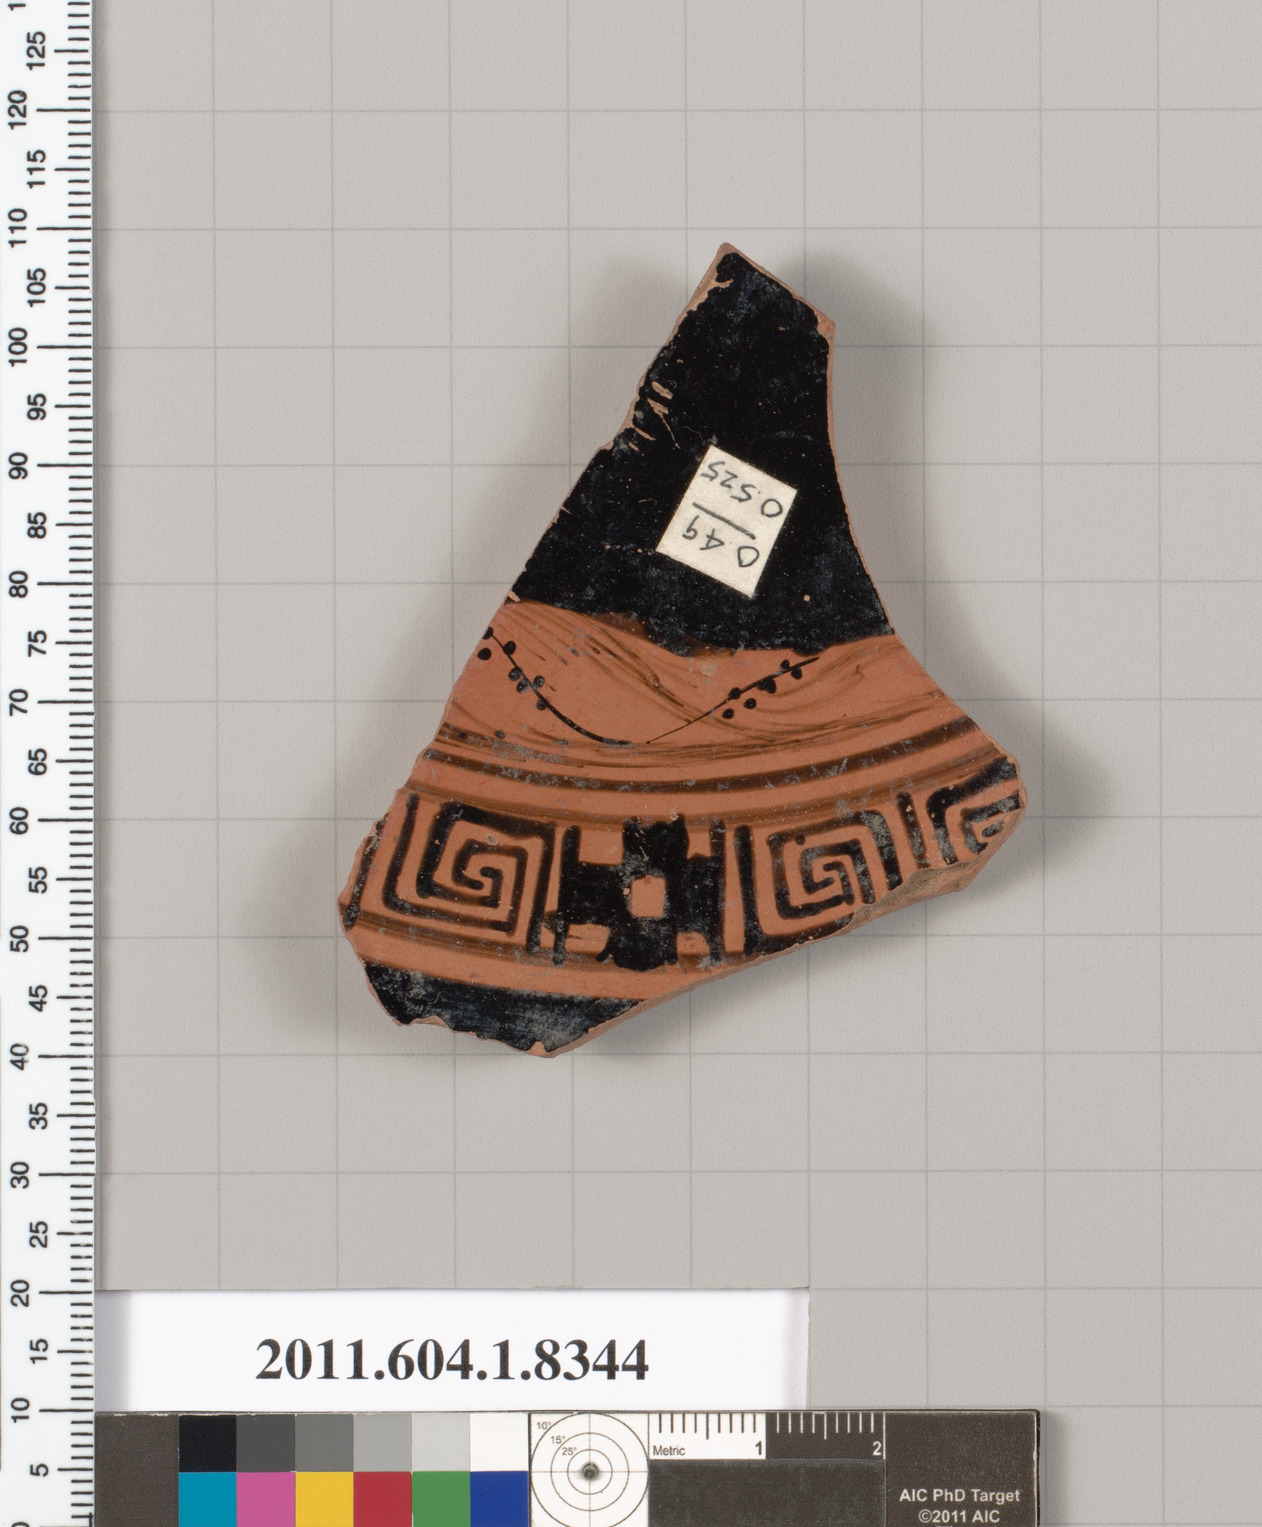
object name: kylix fragment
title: Terracotta fragment of a kylix (drinking cup)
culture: greek, attic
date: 434-368 BCE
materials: terracotta